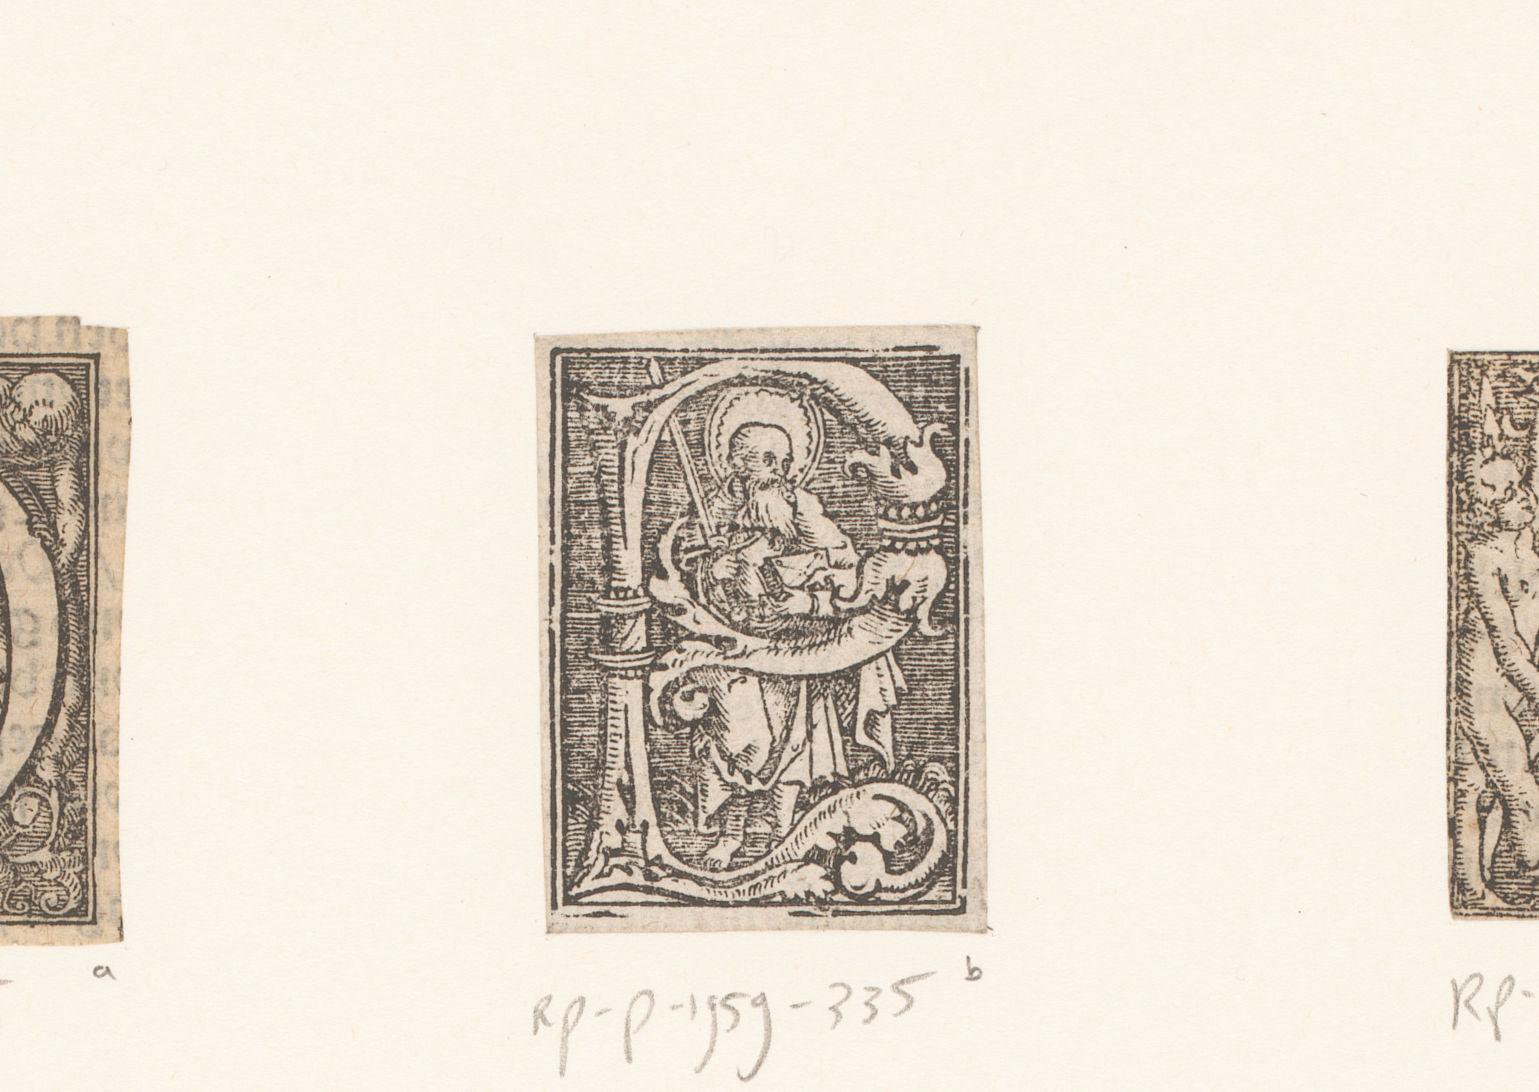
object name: print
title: Versierde letter P met de apostel Paulus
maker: Anonymous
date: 1500-1599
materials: paper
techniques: woodcut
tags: initial, the apostle paul of tarsus; possible attributes: book, scroll, sword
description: Prent afkomstig uit een onbekende publicatie.